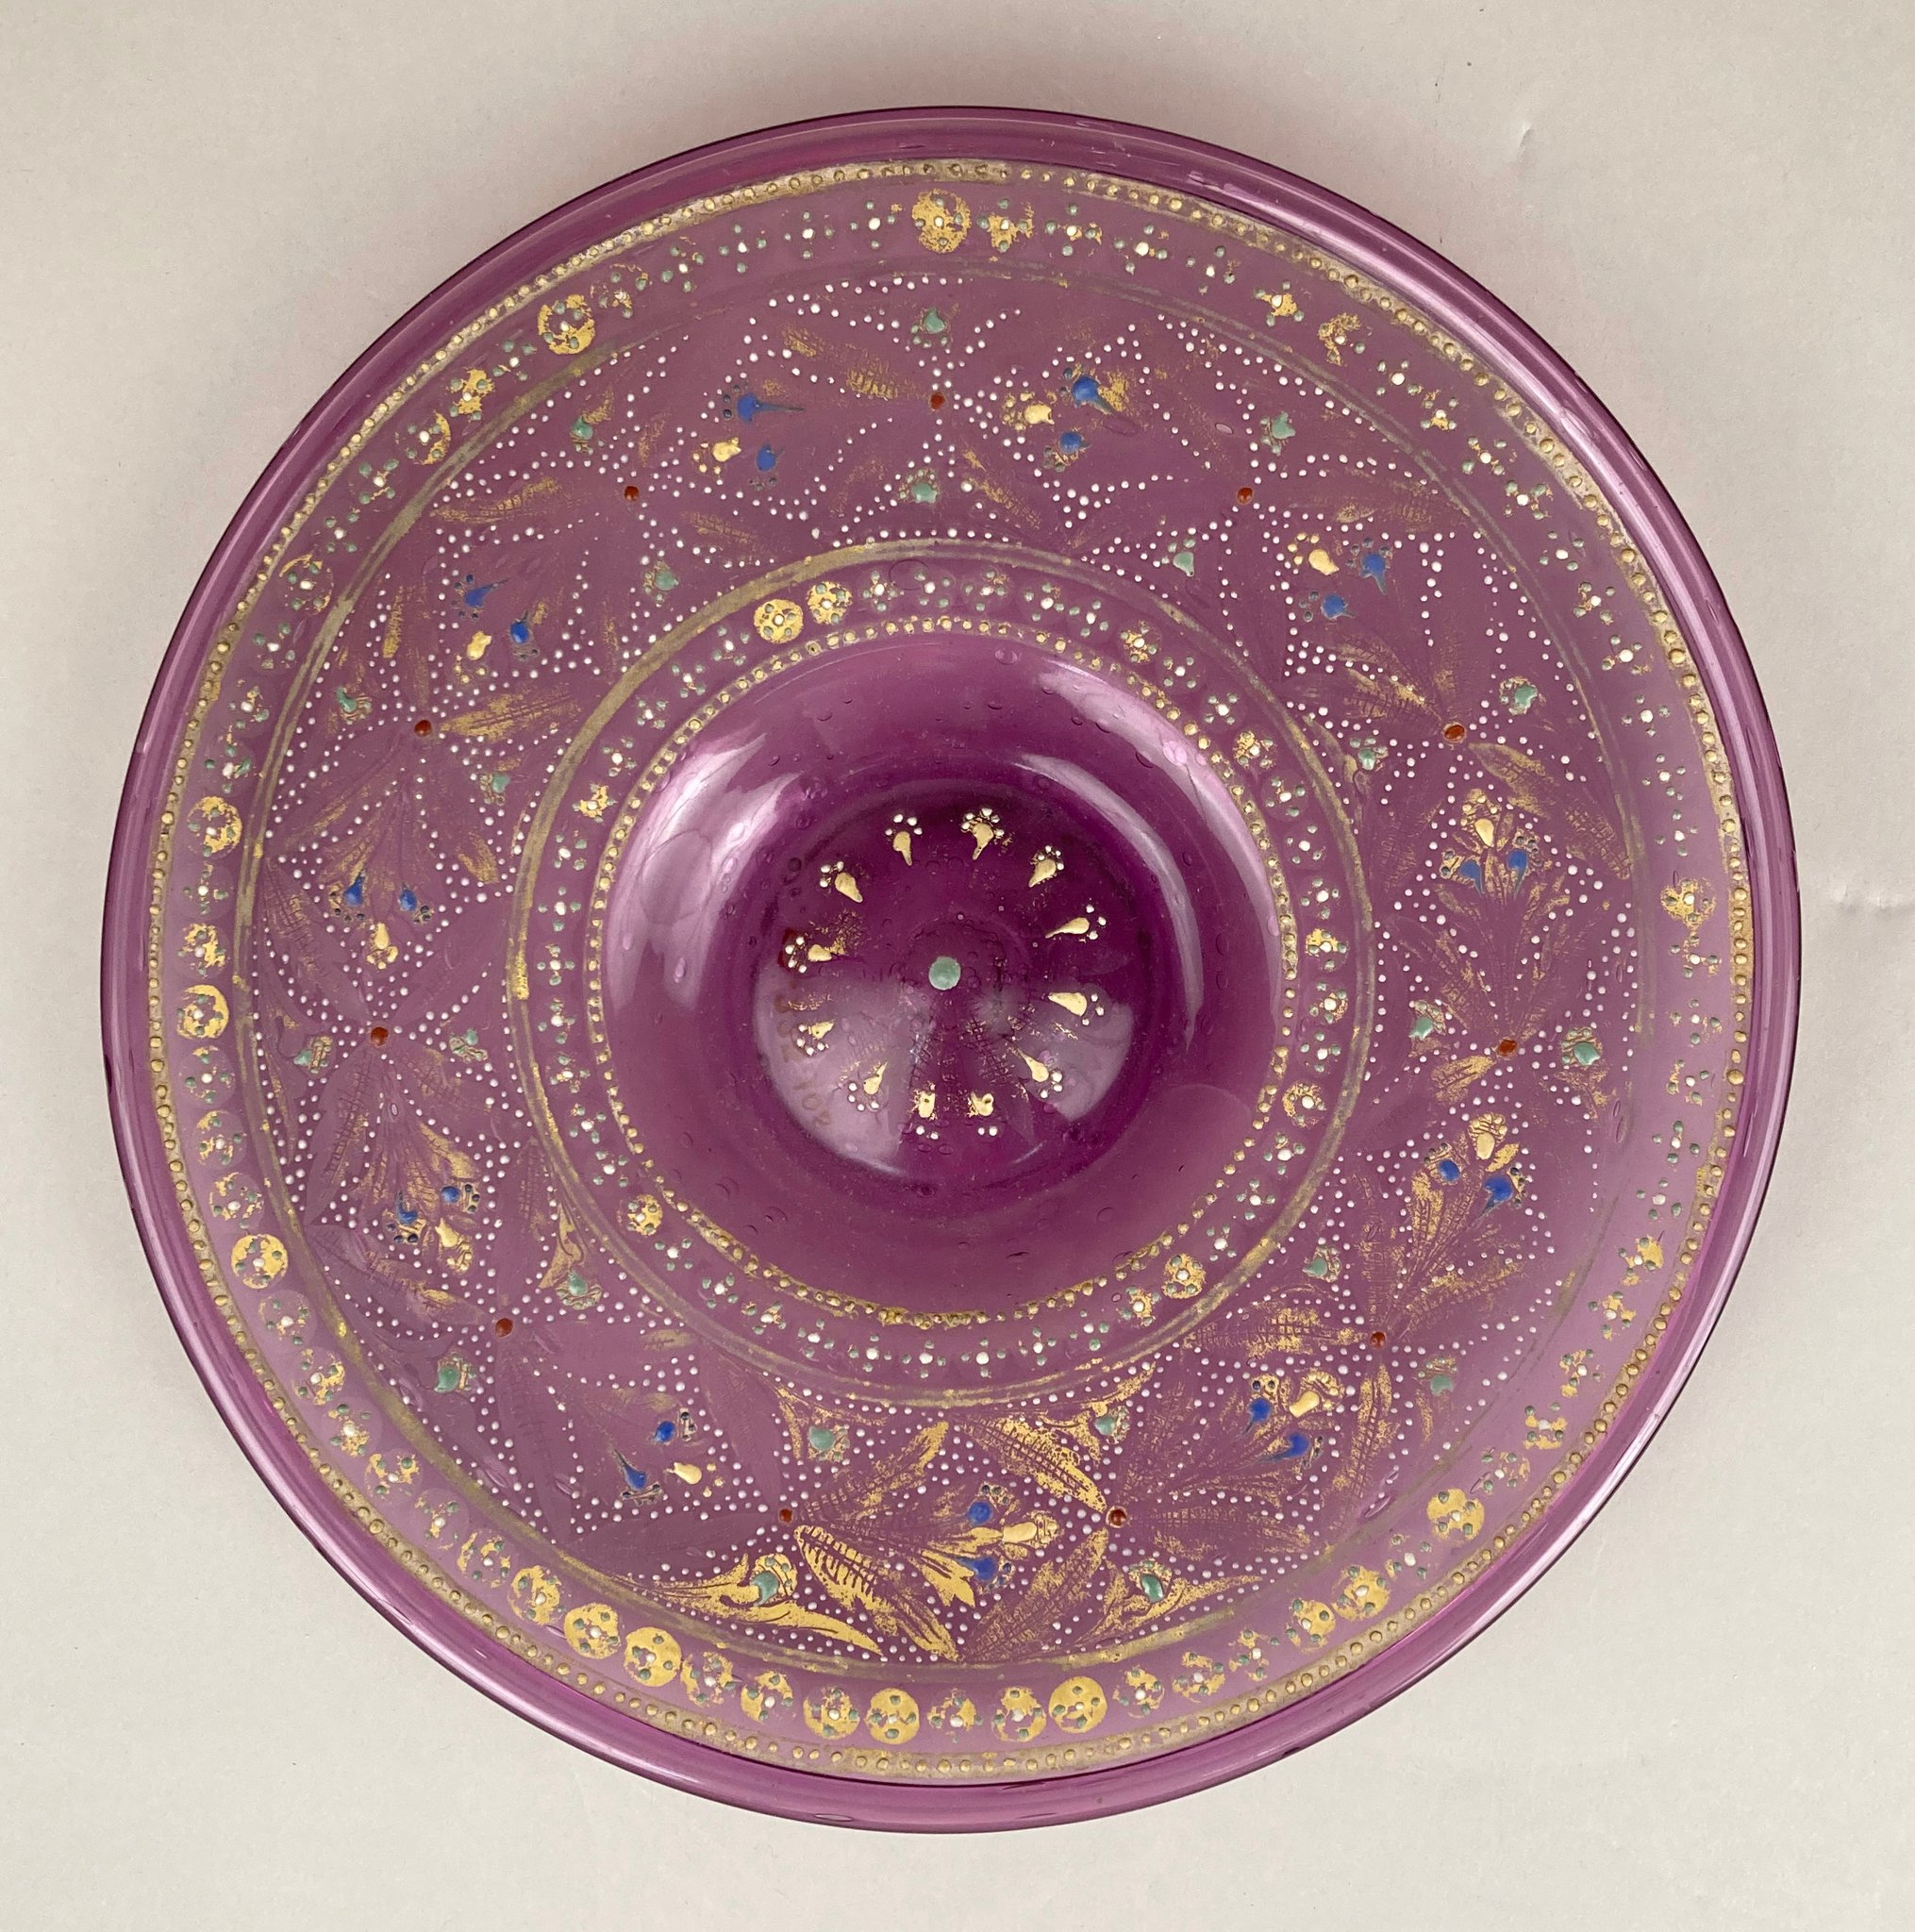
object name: plate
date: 1801-1900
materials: gilt, glass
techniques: enamel